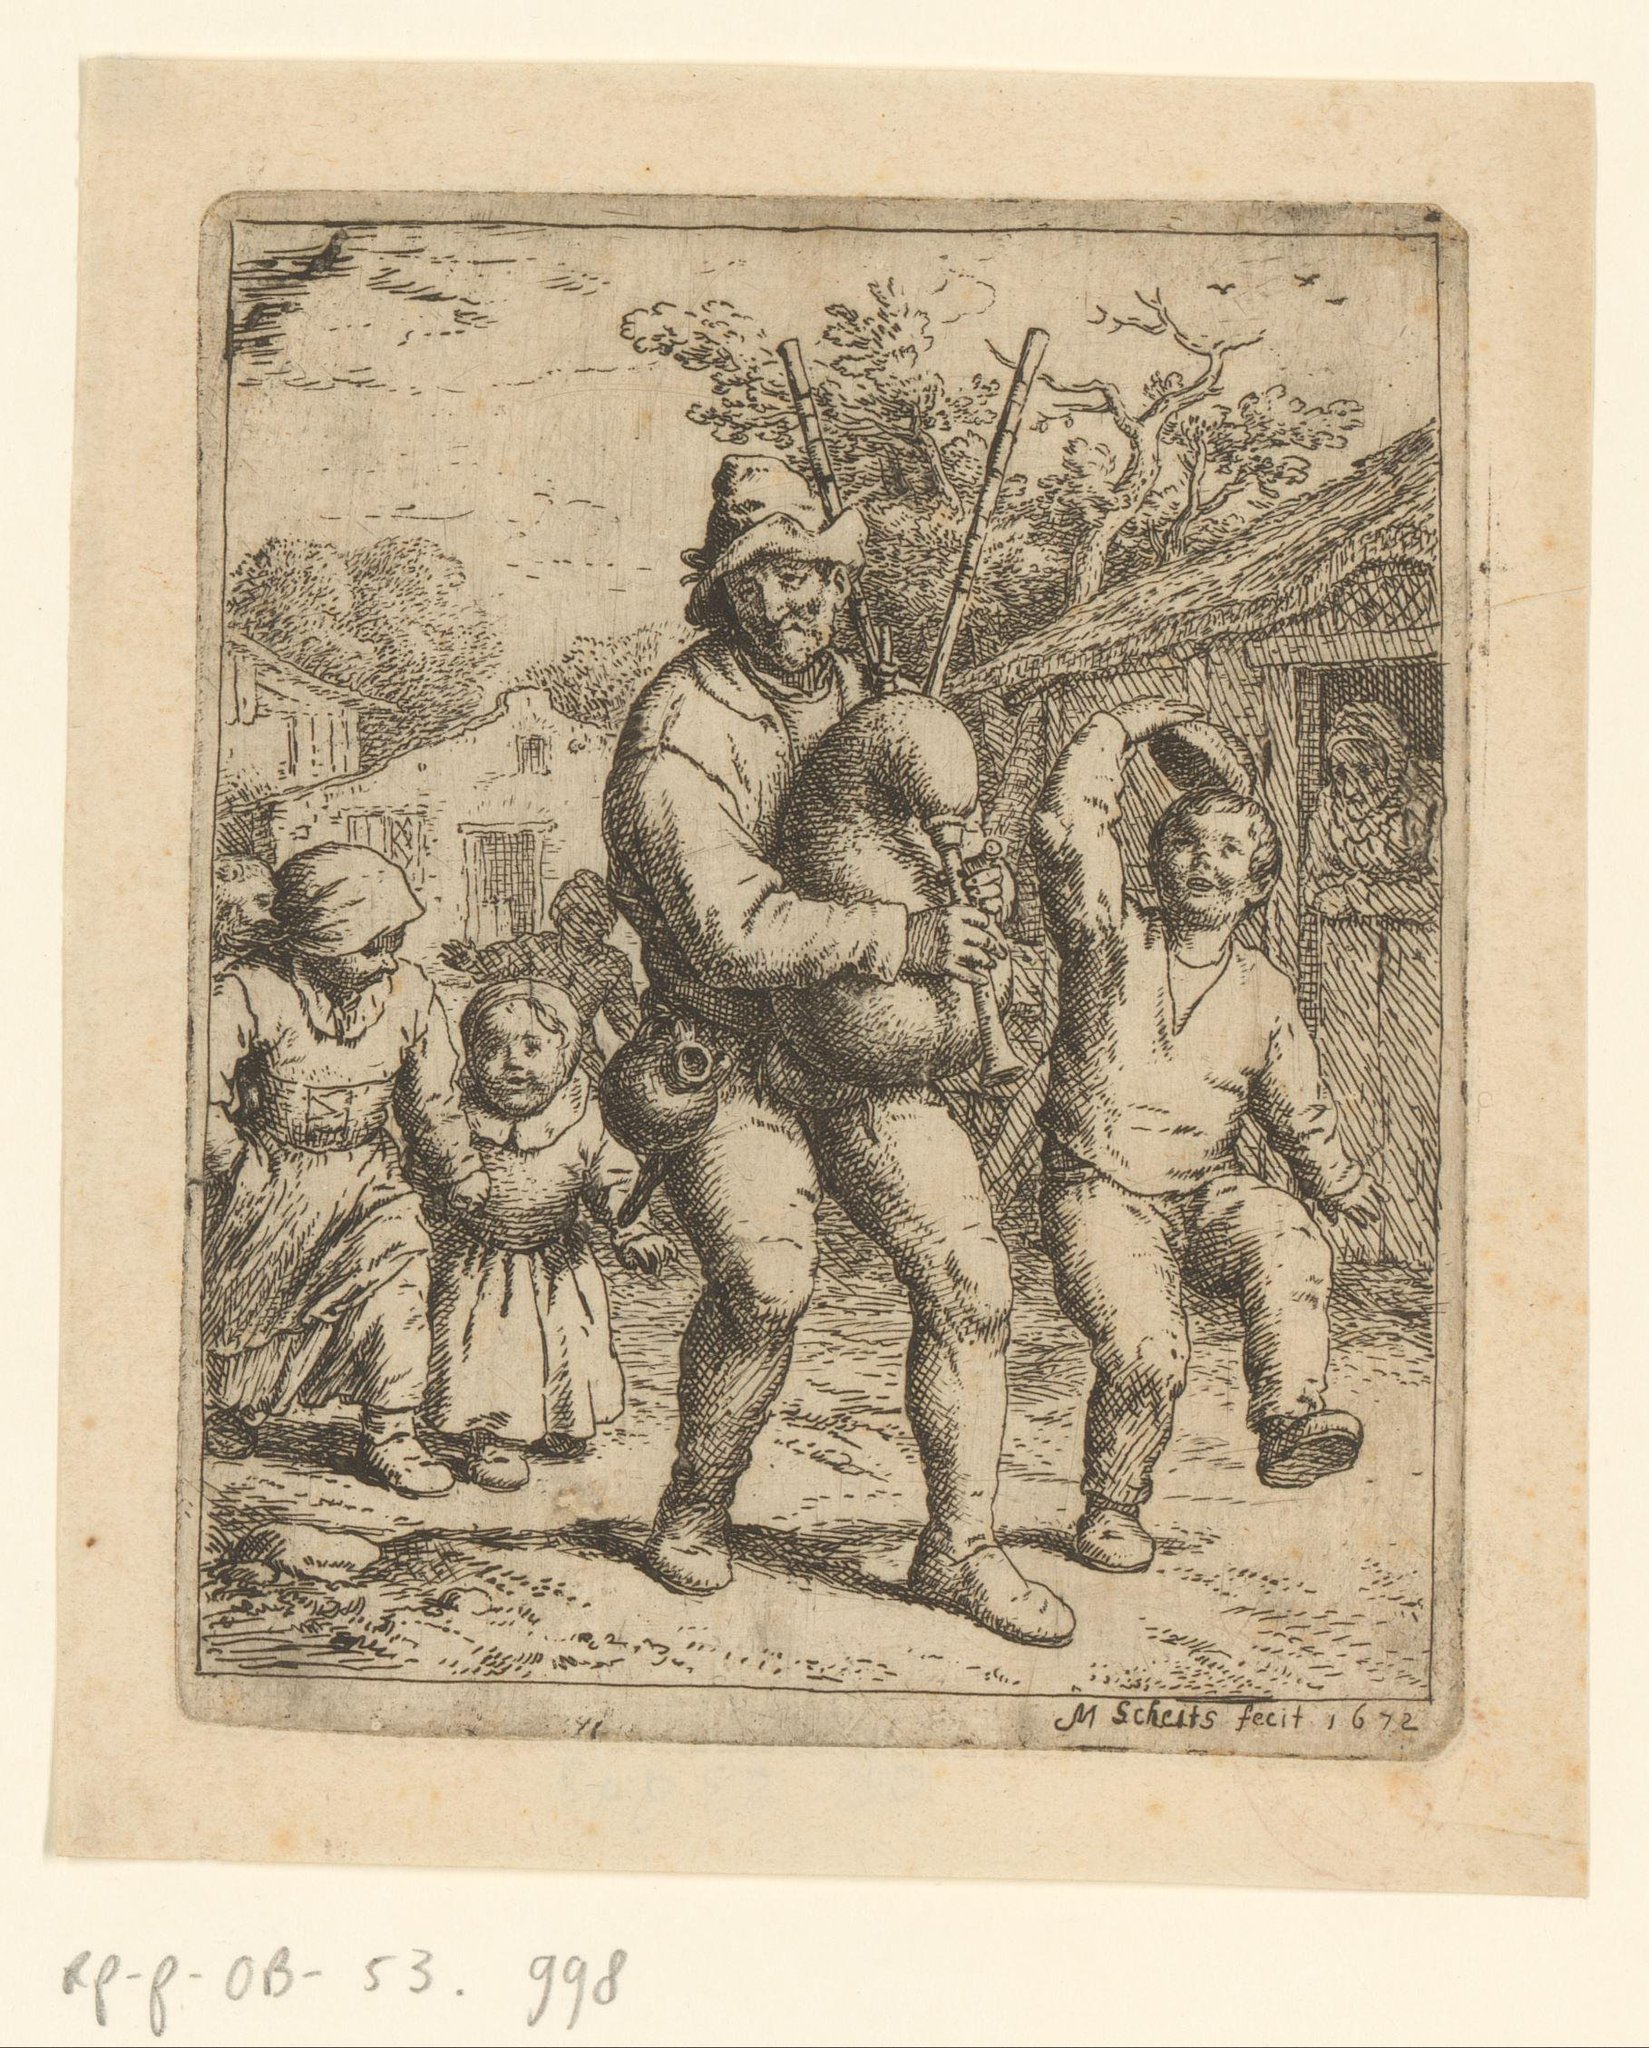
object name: print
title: Doedelzakspeler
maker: matthias scheits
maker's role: print maker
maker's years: 1625-1700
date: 1672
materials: paper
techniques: etching, intaglio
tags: one person playing wind instrument, bagpipe, musette, farmers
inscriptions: collector's mark: Lugt 240